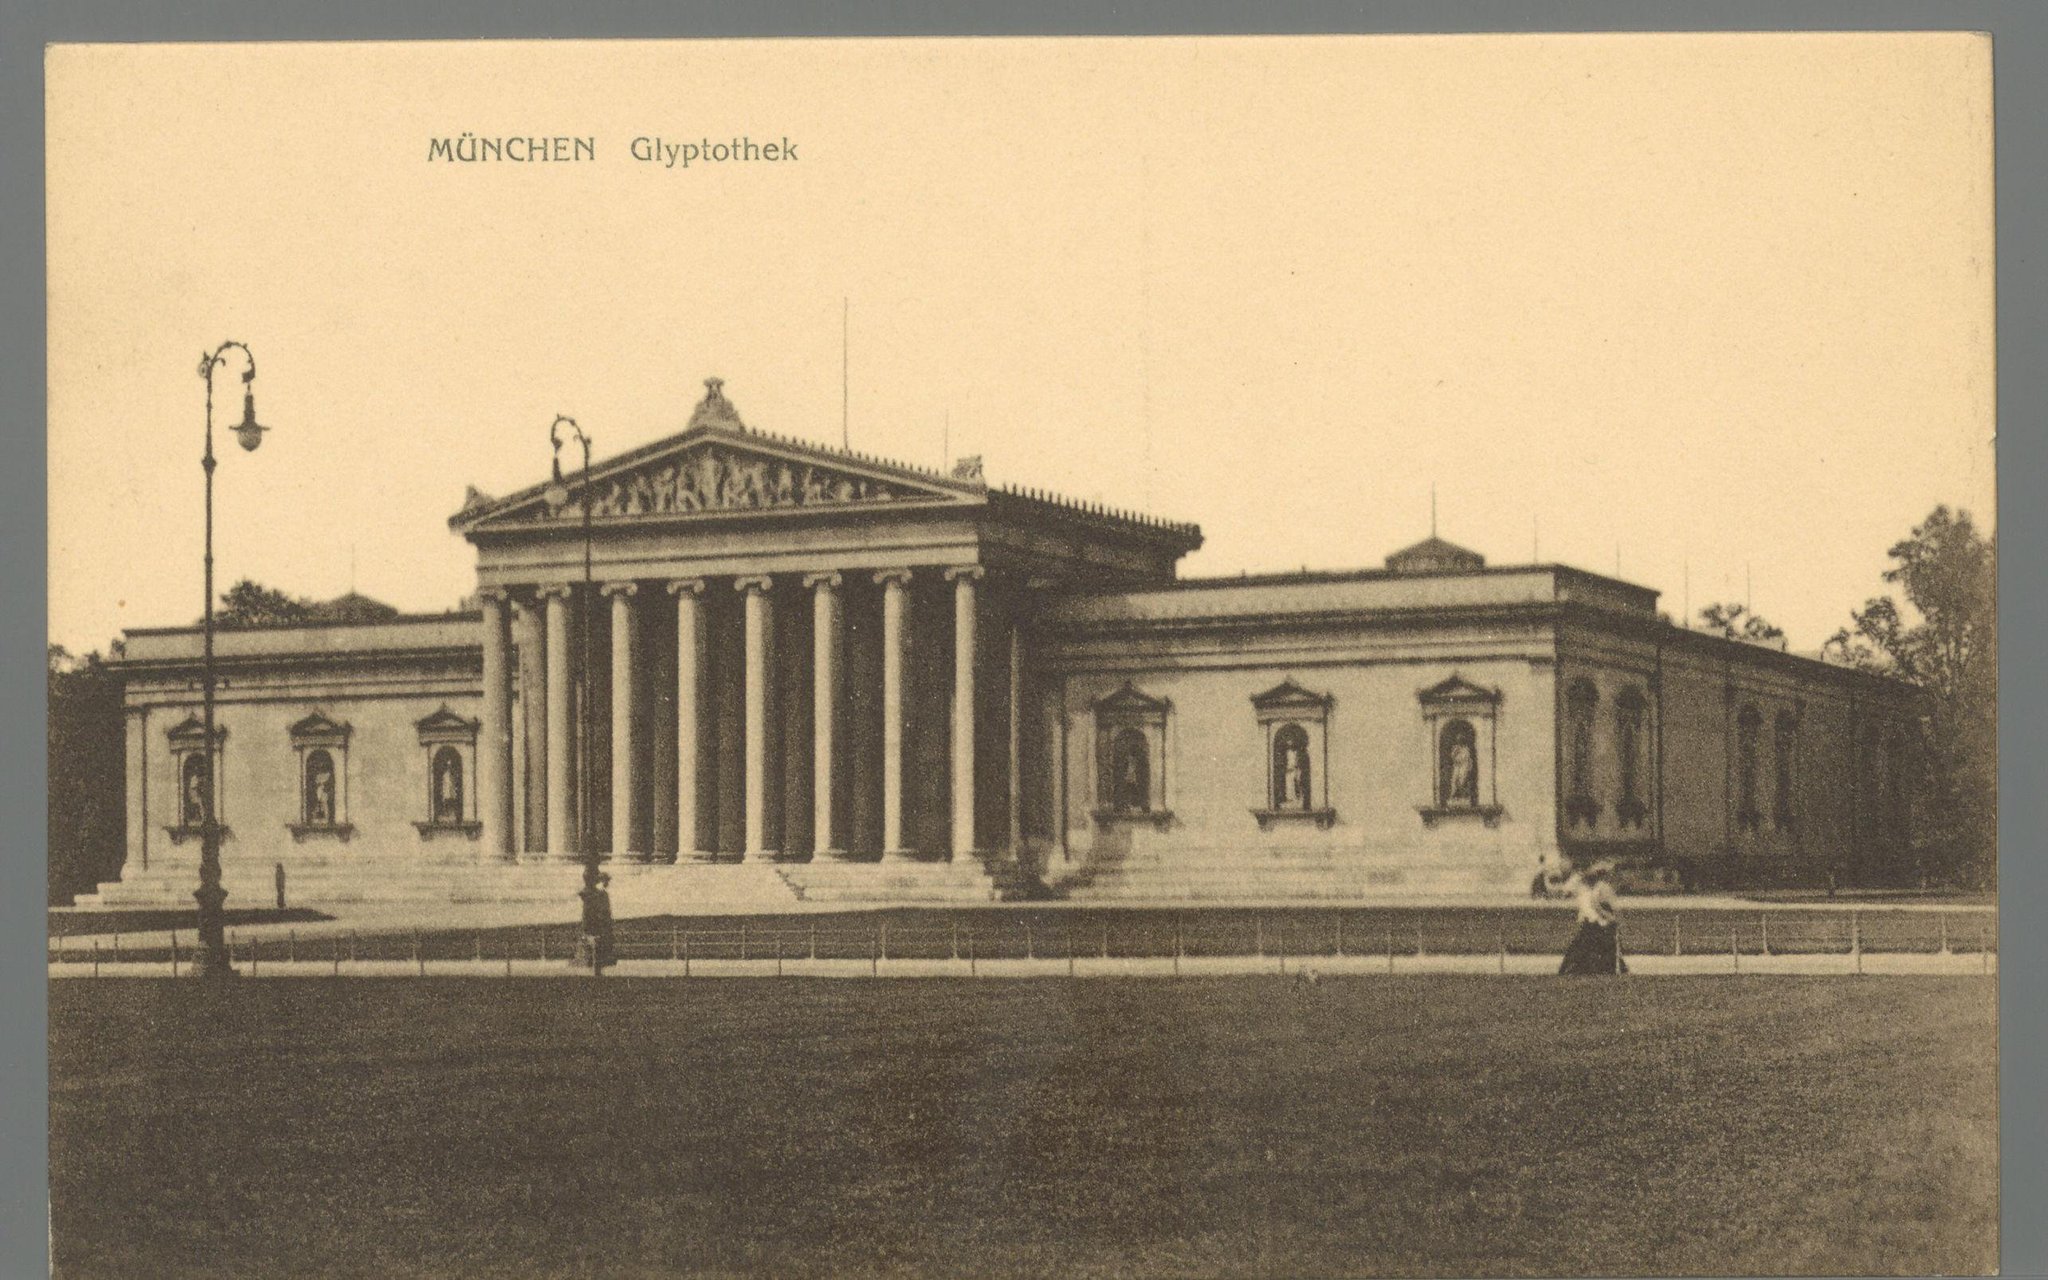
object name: photomechanical print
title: München. Glyptothek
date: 1905-1930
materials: cardboard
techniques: photograph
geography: munich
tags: permanent exhibition, museum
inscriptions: inscription: ‘W.H.D.’